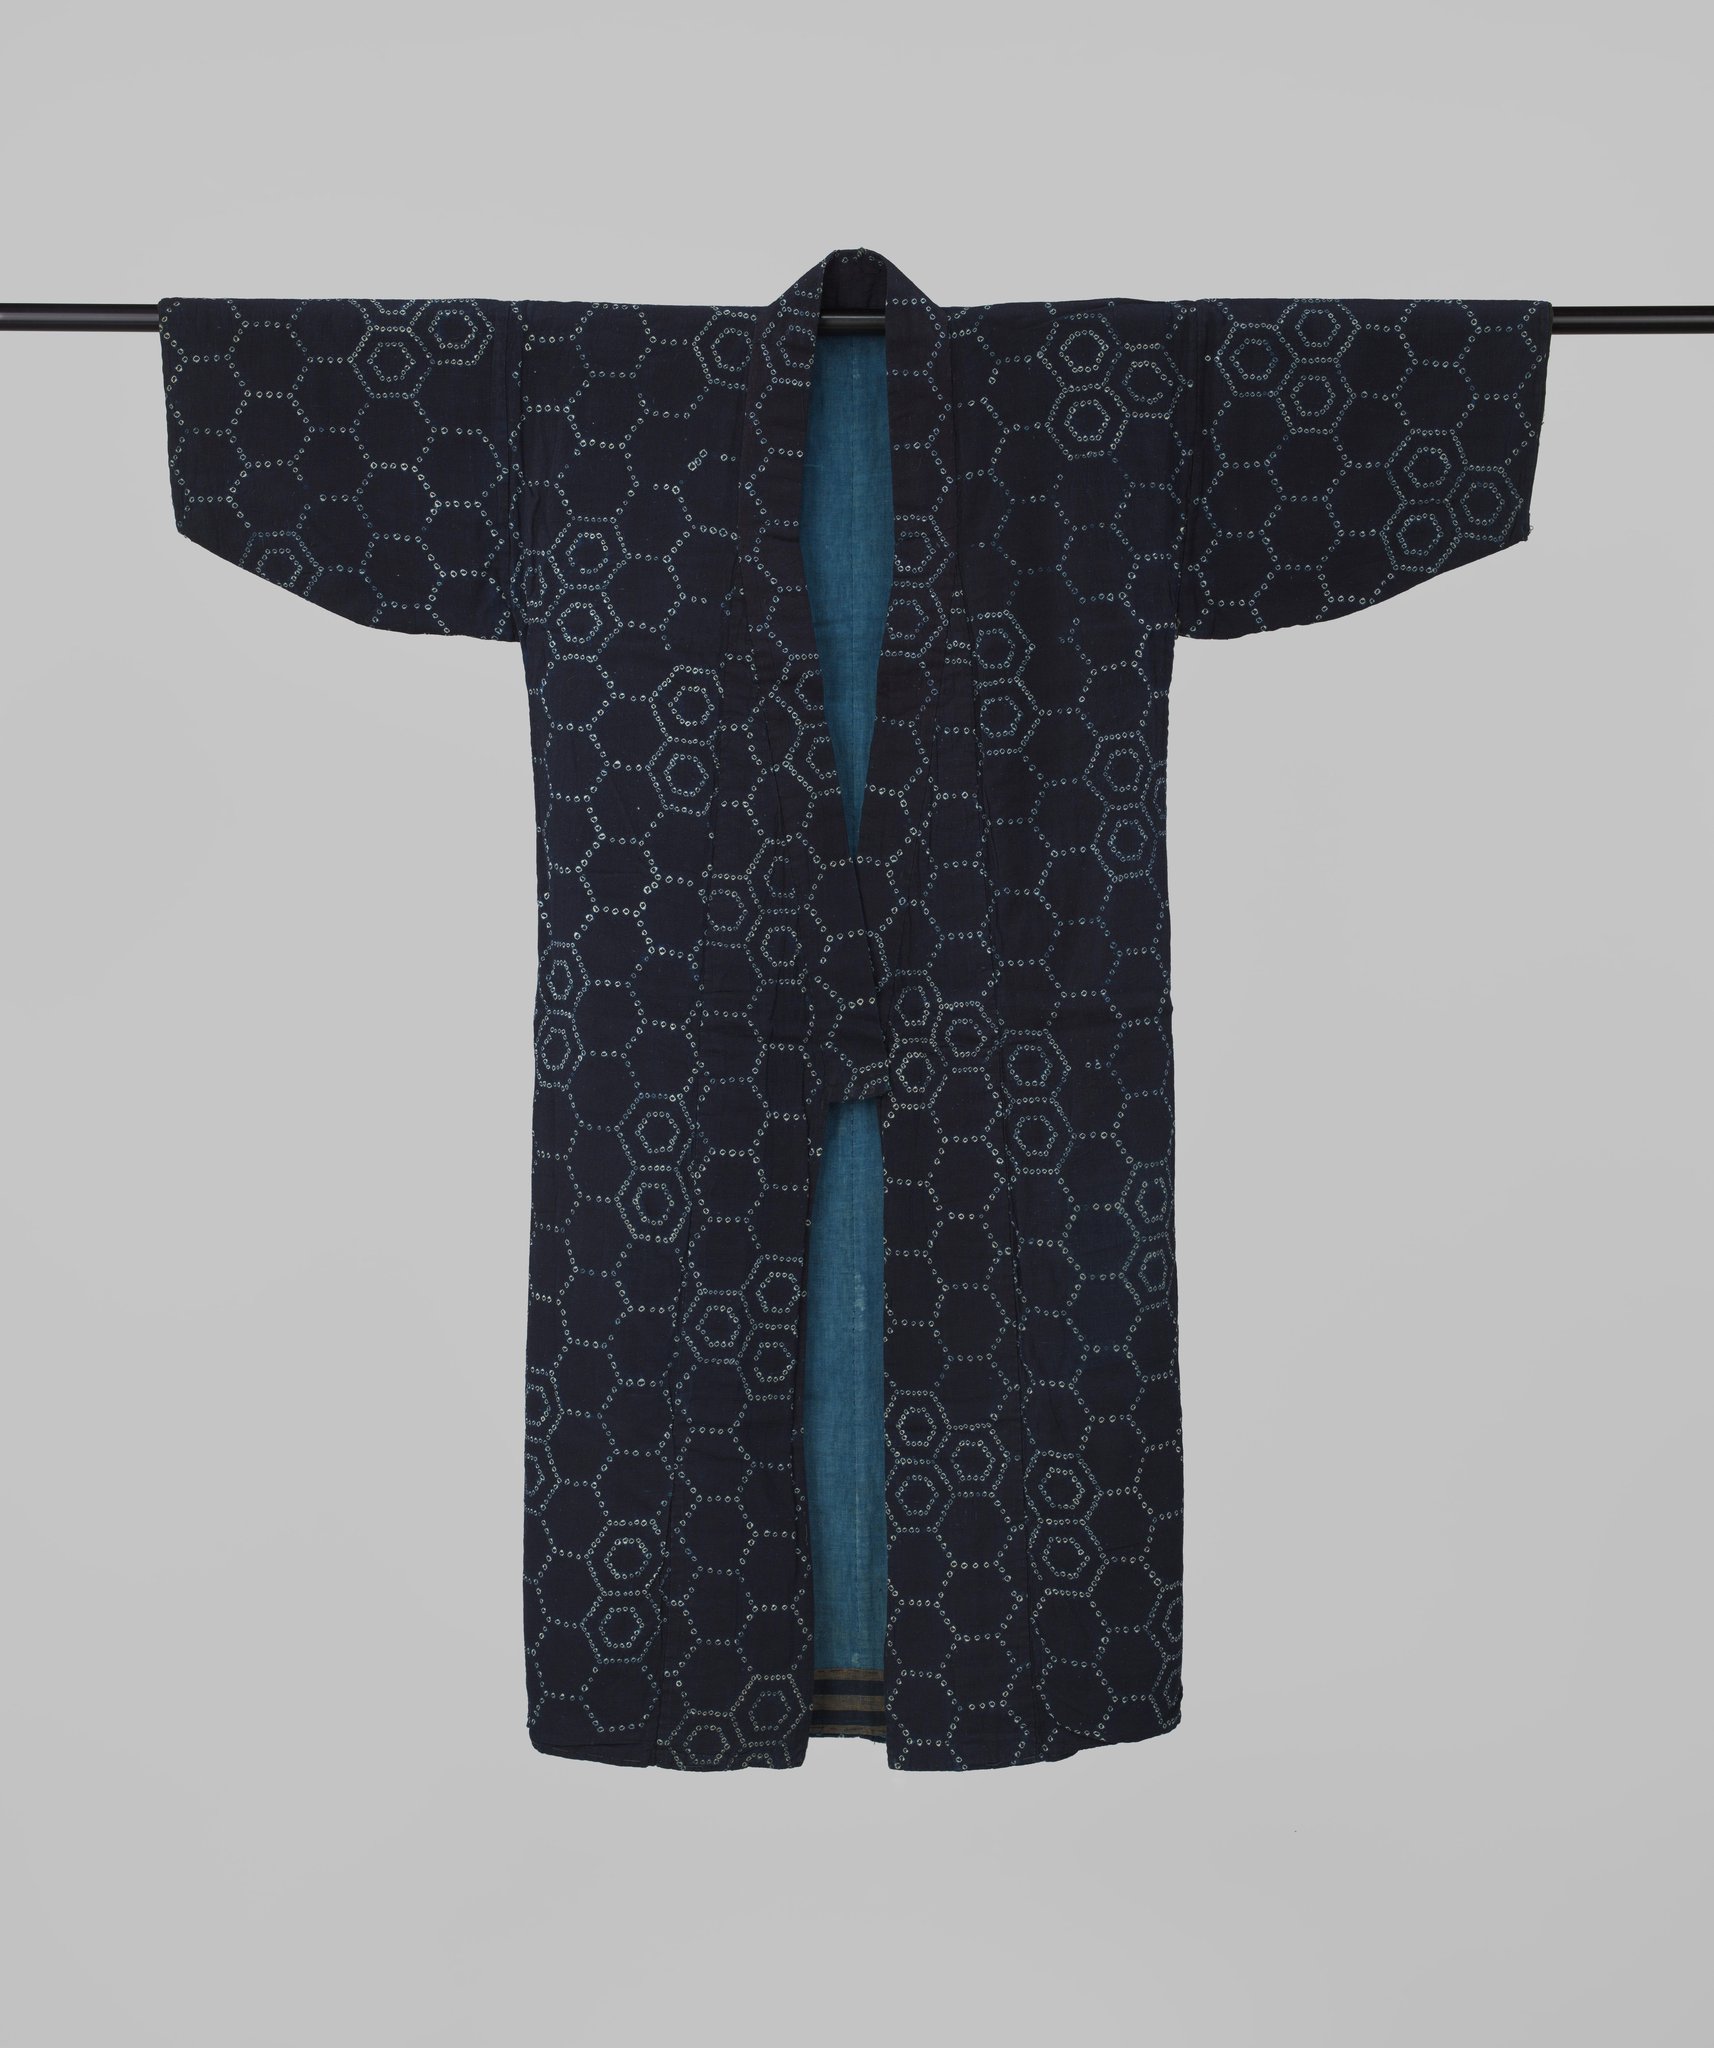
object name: kimono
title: Mannen kimono met schildpad motief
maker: Anonymous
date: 1900-1920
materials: cotton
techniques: painting, weave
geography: japan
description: Kimono voor een man met een versiering over het hele vlak van een schildpad motief: aaneensluitende zeshoeken waarvan sommige ingevuld met een kleindere zeshoek. Indigo katoen met tie-dye decoratie. Voering van indigo katoen.